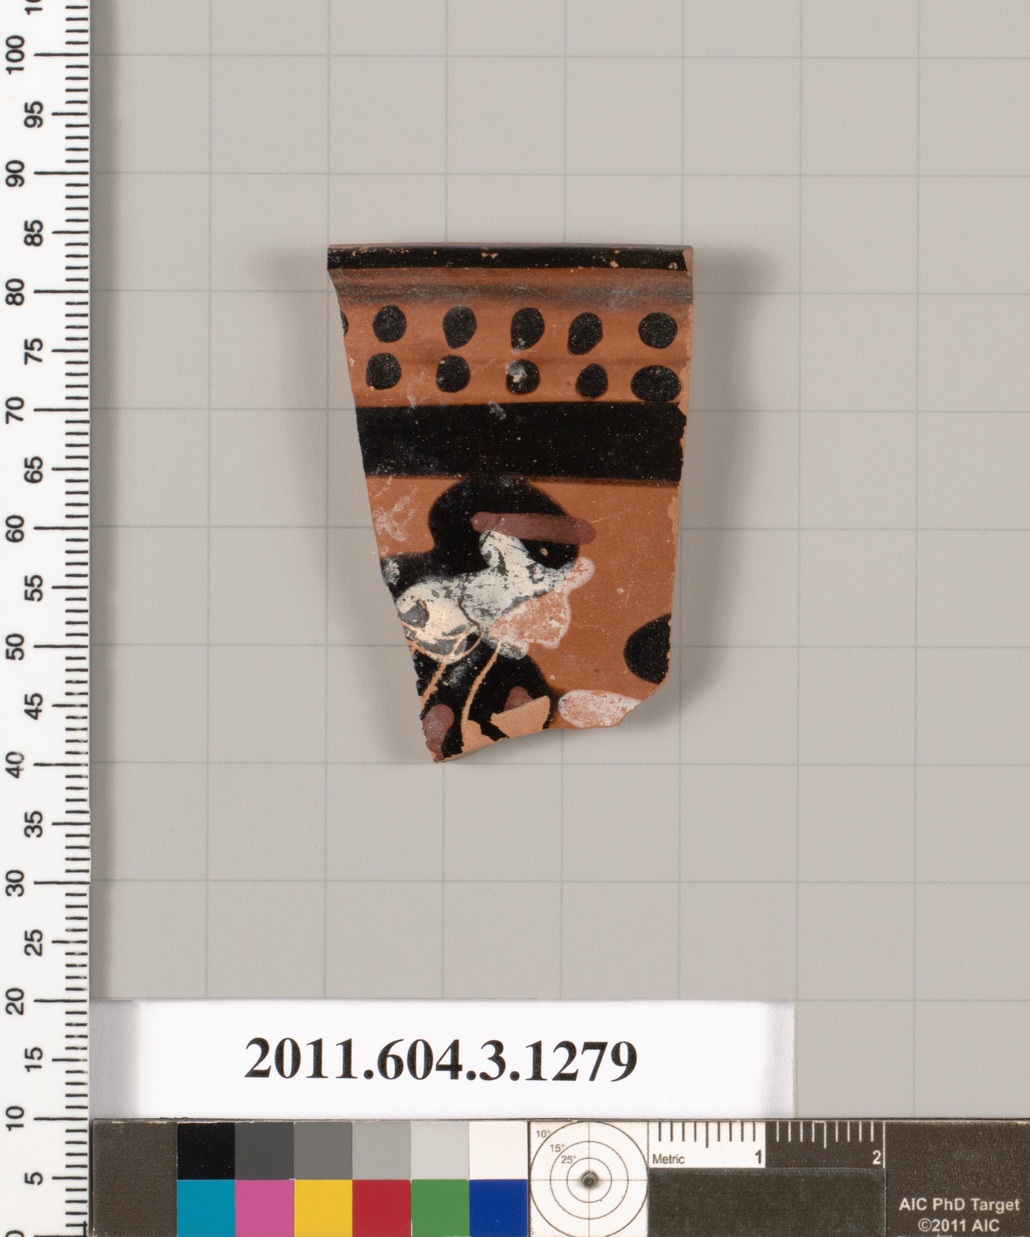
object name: skyphos fragment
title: Terracotta rim fragment of a skyphos (deep drinking cup)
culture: greek, attic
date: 500 BCE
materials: terracotta